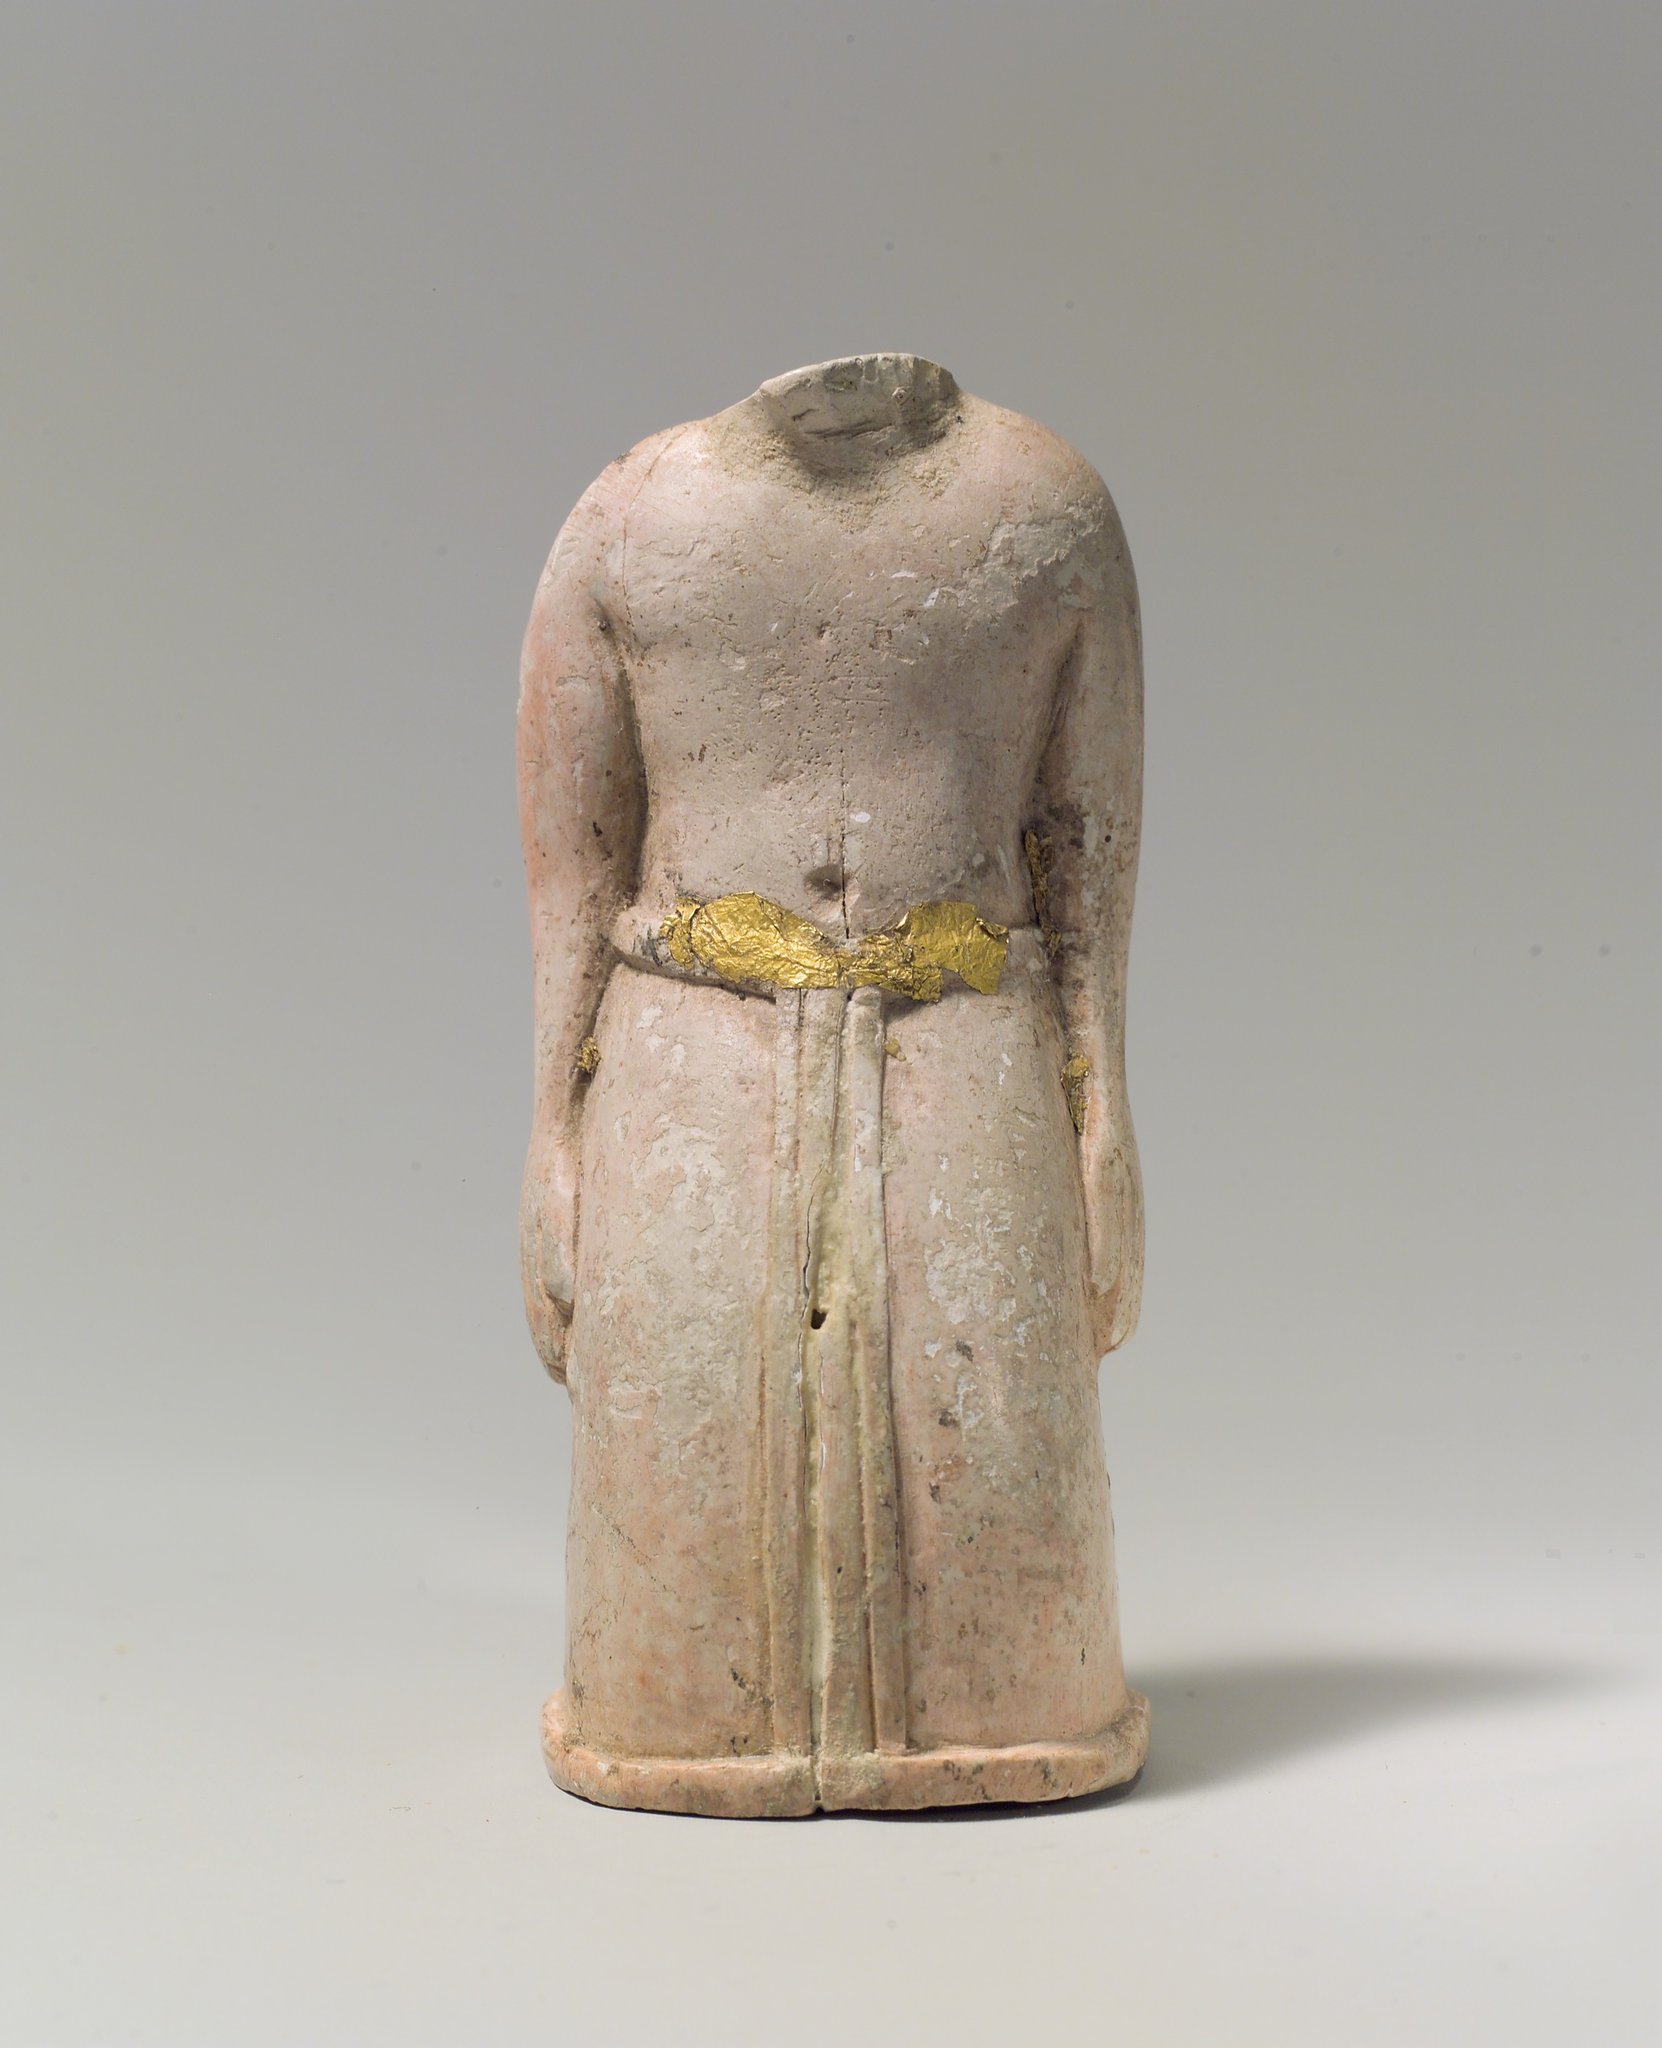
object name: furniture element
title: Furniture element: kneeling male figure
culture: assyrian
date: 1800-1701 BCE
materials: gold leaf, ivory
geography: anatolia